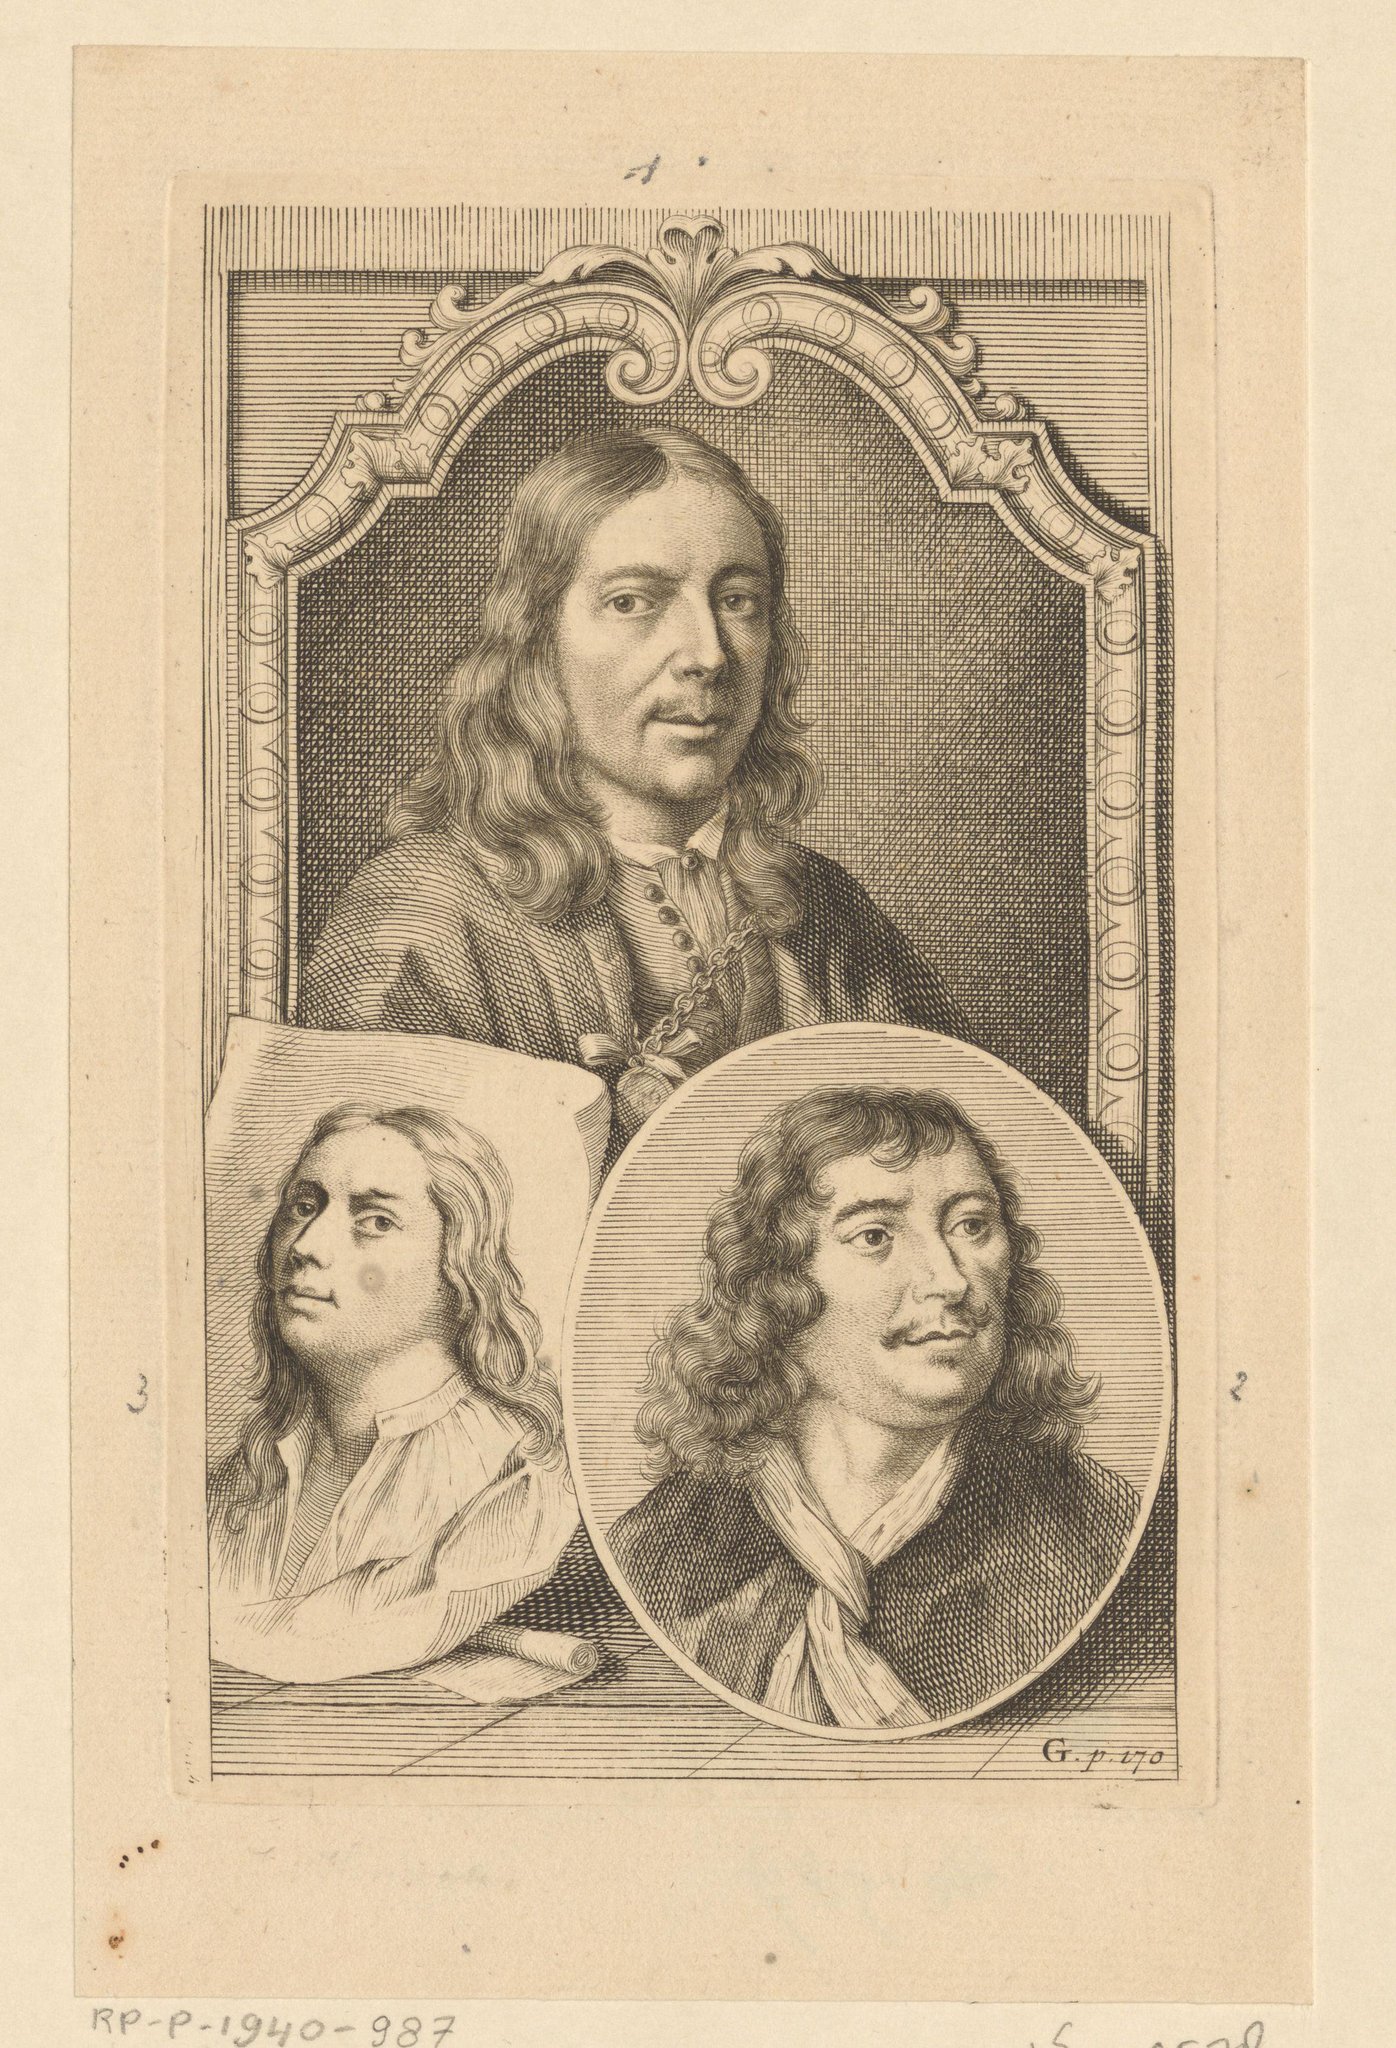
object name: book illustration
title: Portretten van Samuel van Hoogstraten, Jan van Hoogstraten en Johannes Lingelbach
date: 1719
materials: paper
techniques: engraving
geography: amsterdam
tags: samuel van hoogstraten, amsterdam, draughtsman, johannes lingelbach, the hague, vienna, jan van hoogstraten (1627-1654), historical persons, portrait, self-portrait of painter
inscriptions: collector's mark: Lugt 2760, collector's mark: Lugt 2228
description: Prent uit: Houbraken, Arnold. De groote schouburgh der Nederlantsche konstschilders en schilderessen (...). Amsterdam: Arnold Houbraken, 1719, dl. 2. Prent ook gebruikt in latere edities van dit werk.